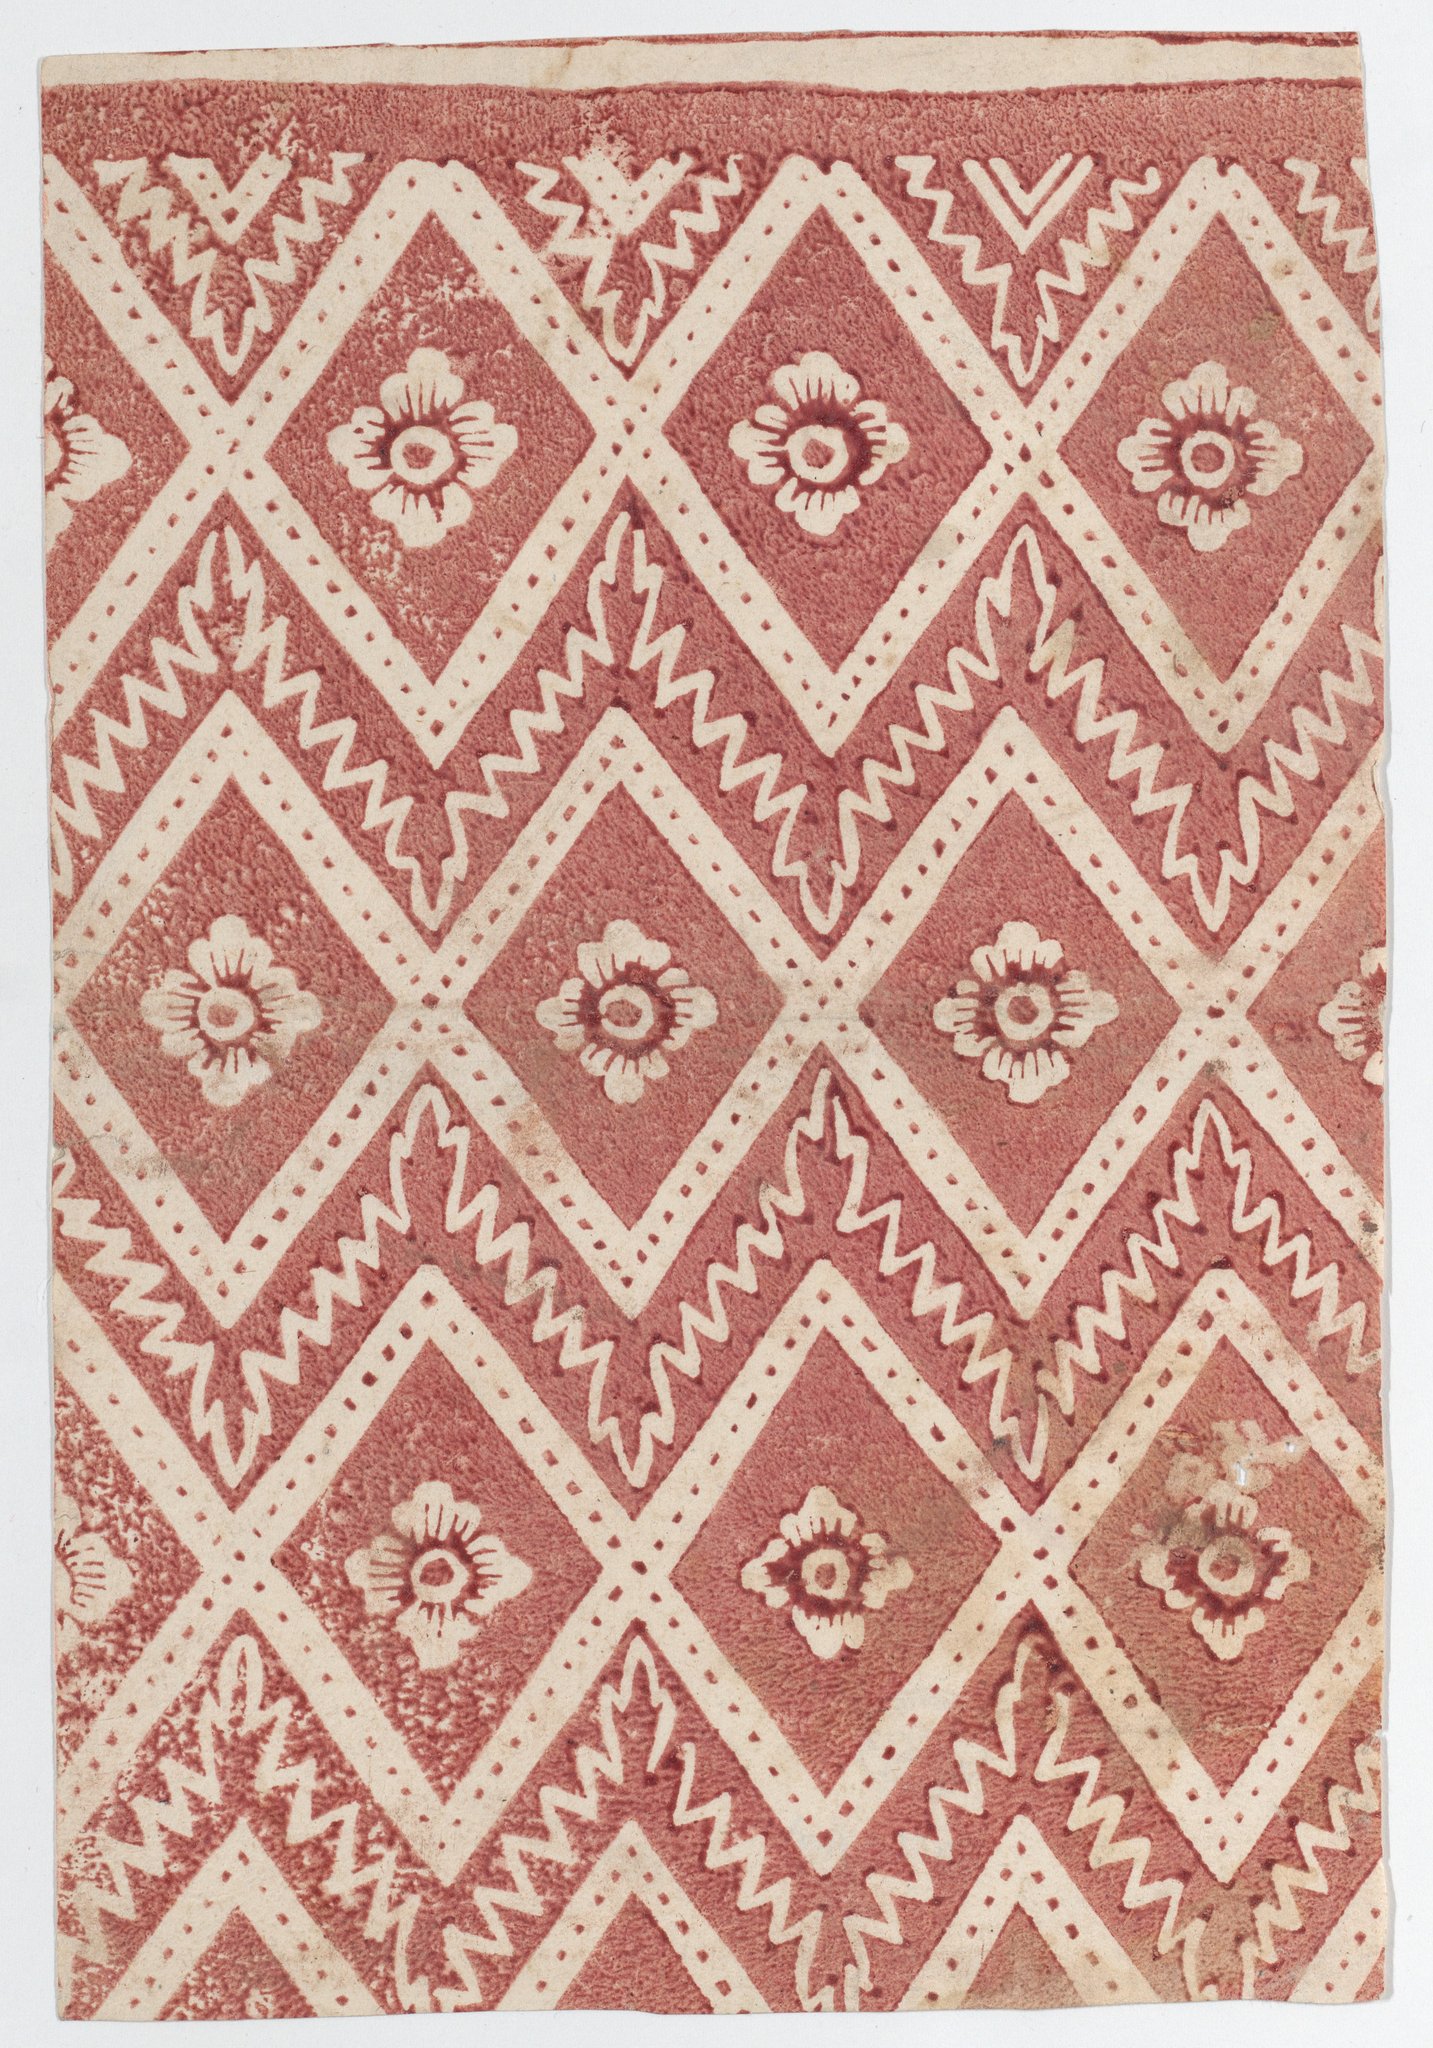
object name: print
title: Sheet with red diamond and zigzag pattern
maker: Anonymous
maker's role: artist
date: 1701-1800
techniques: relief print